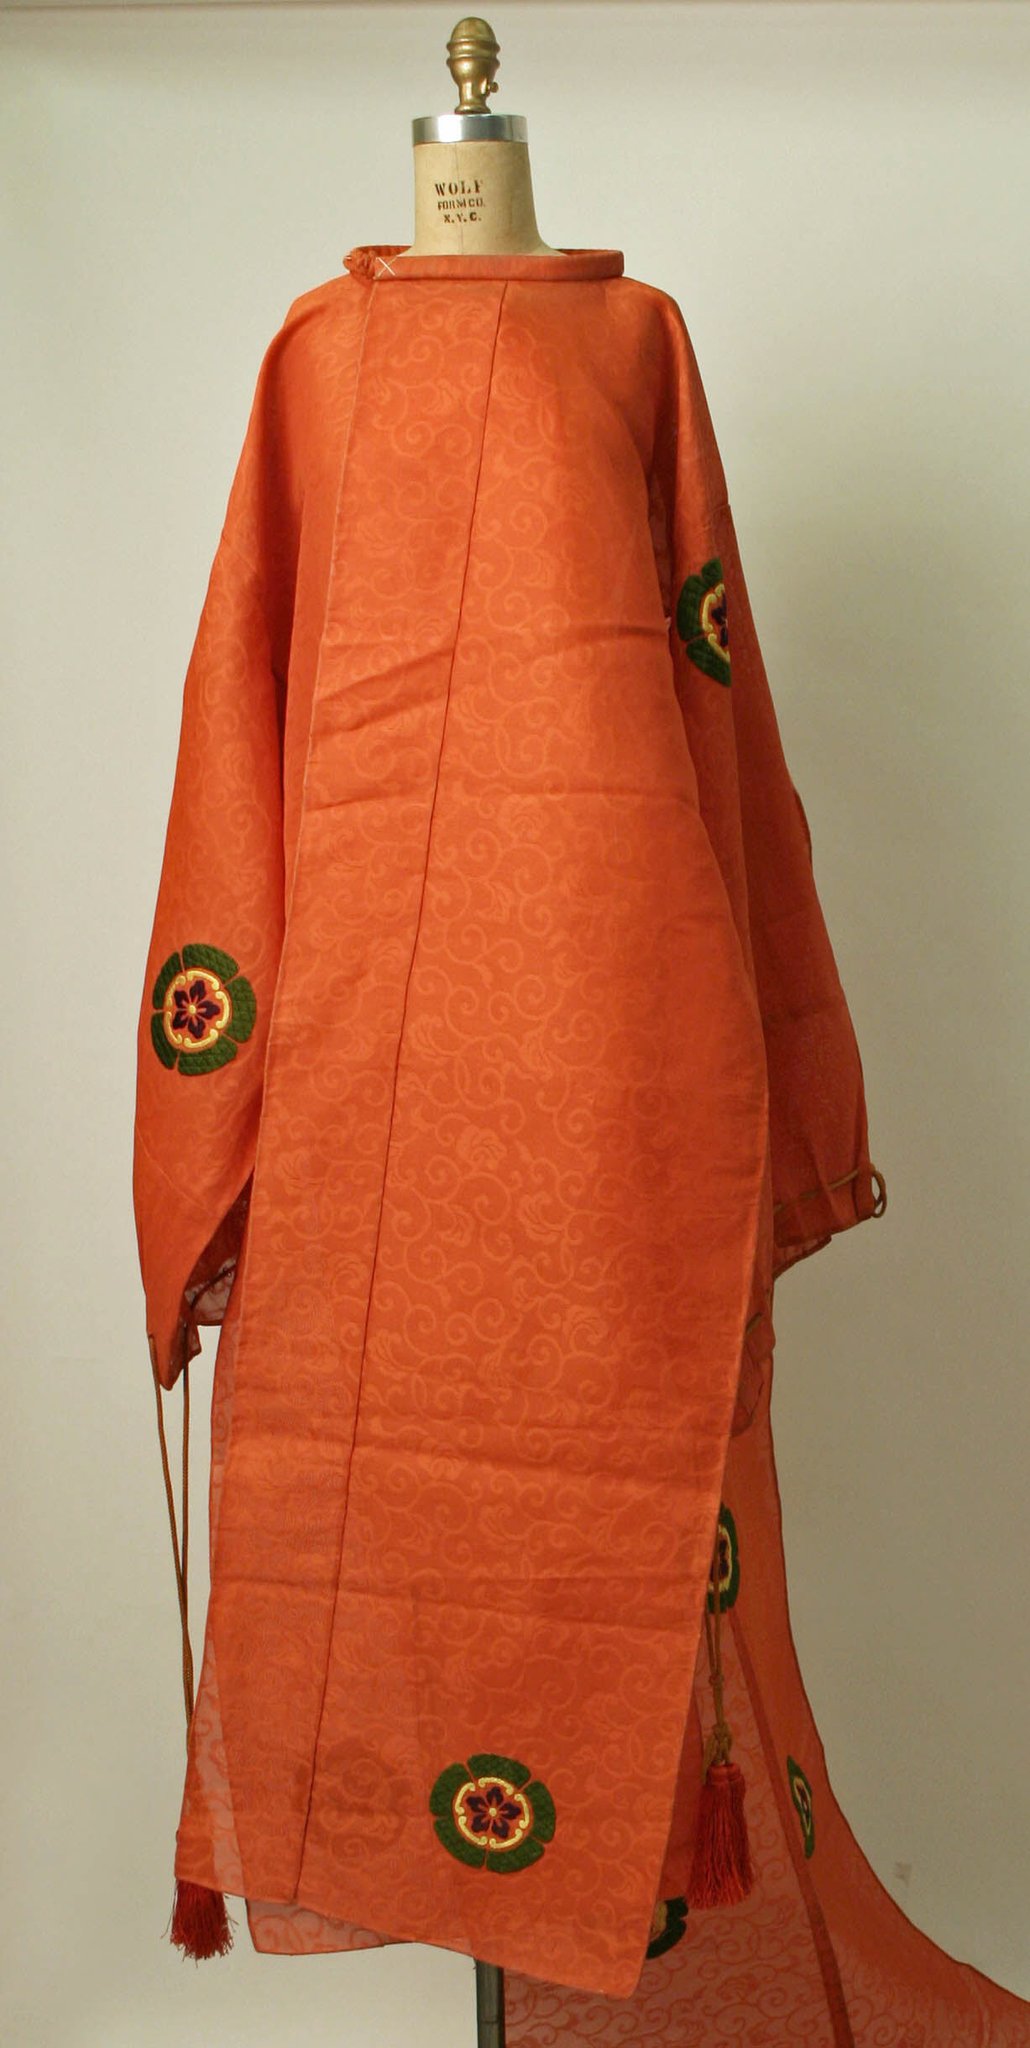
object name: dance ensemble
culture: japanese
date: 1901-2000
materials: silk